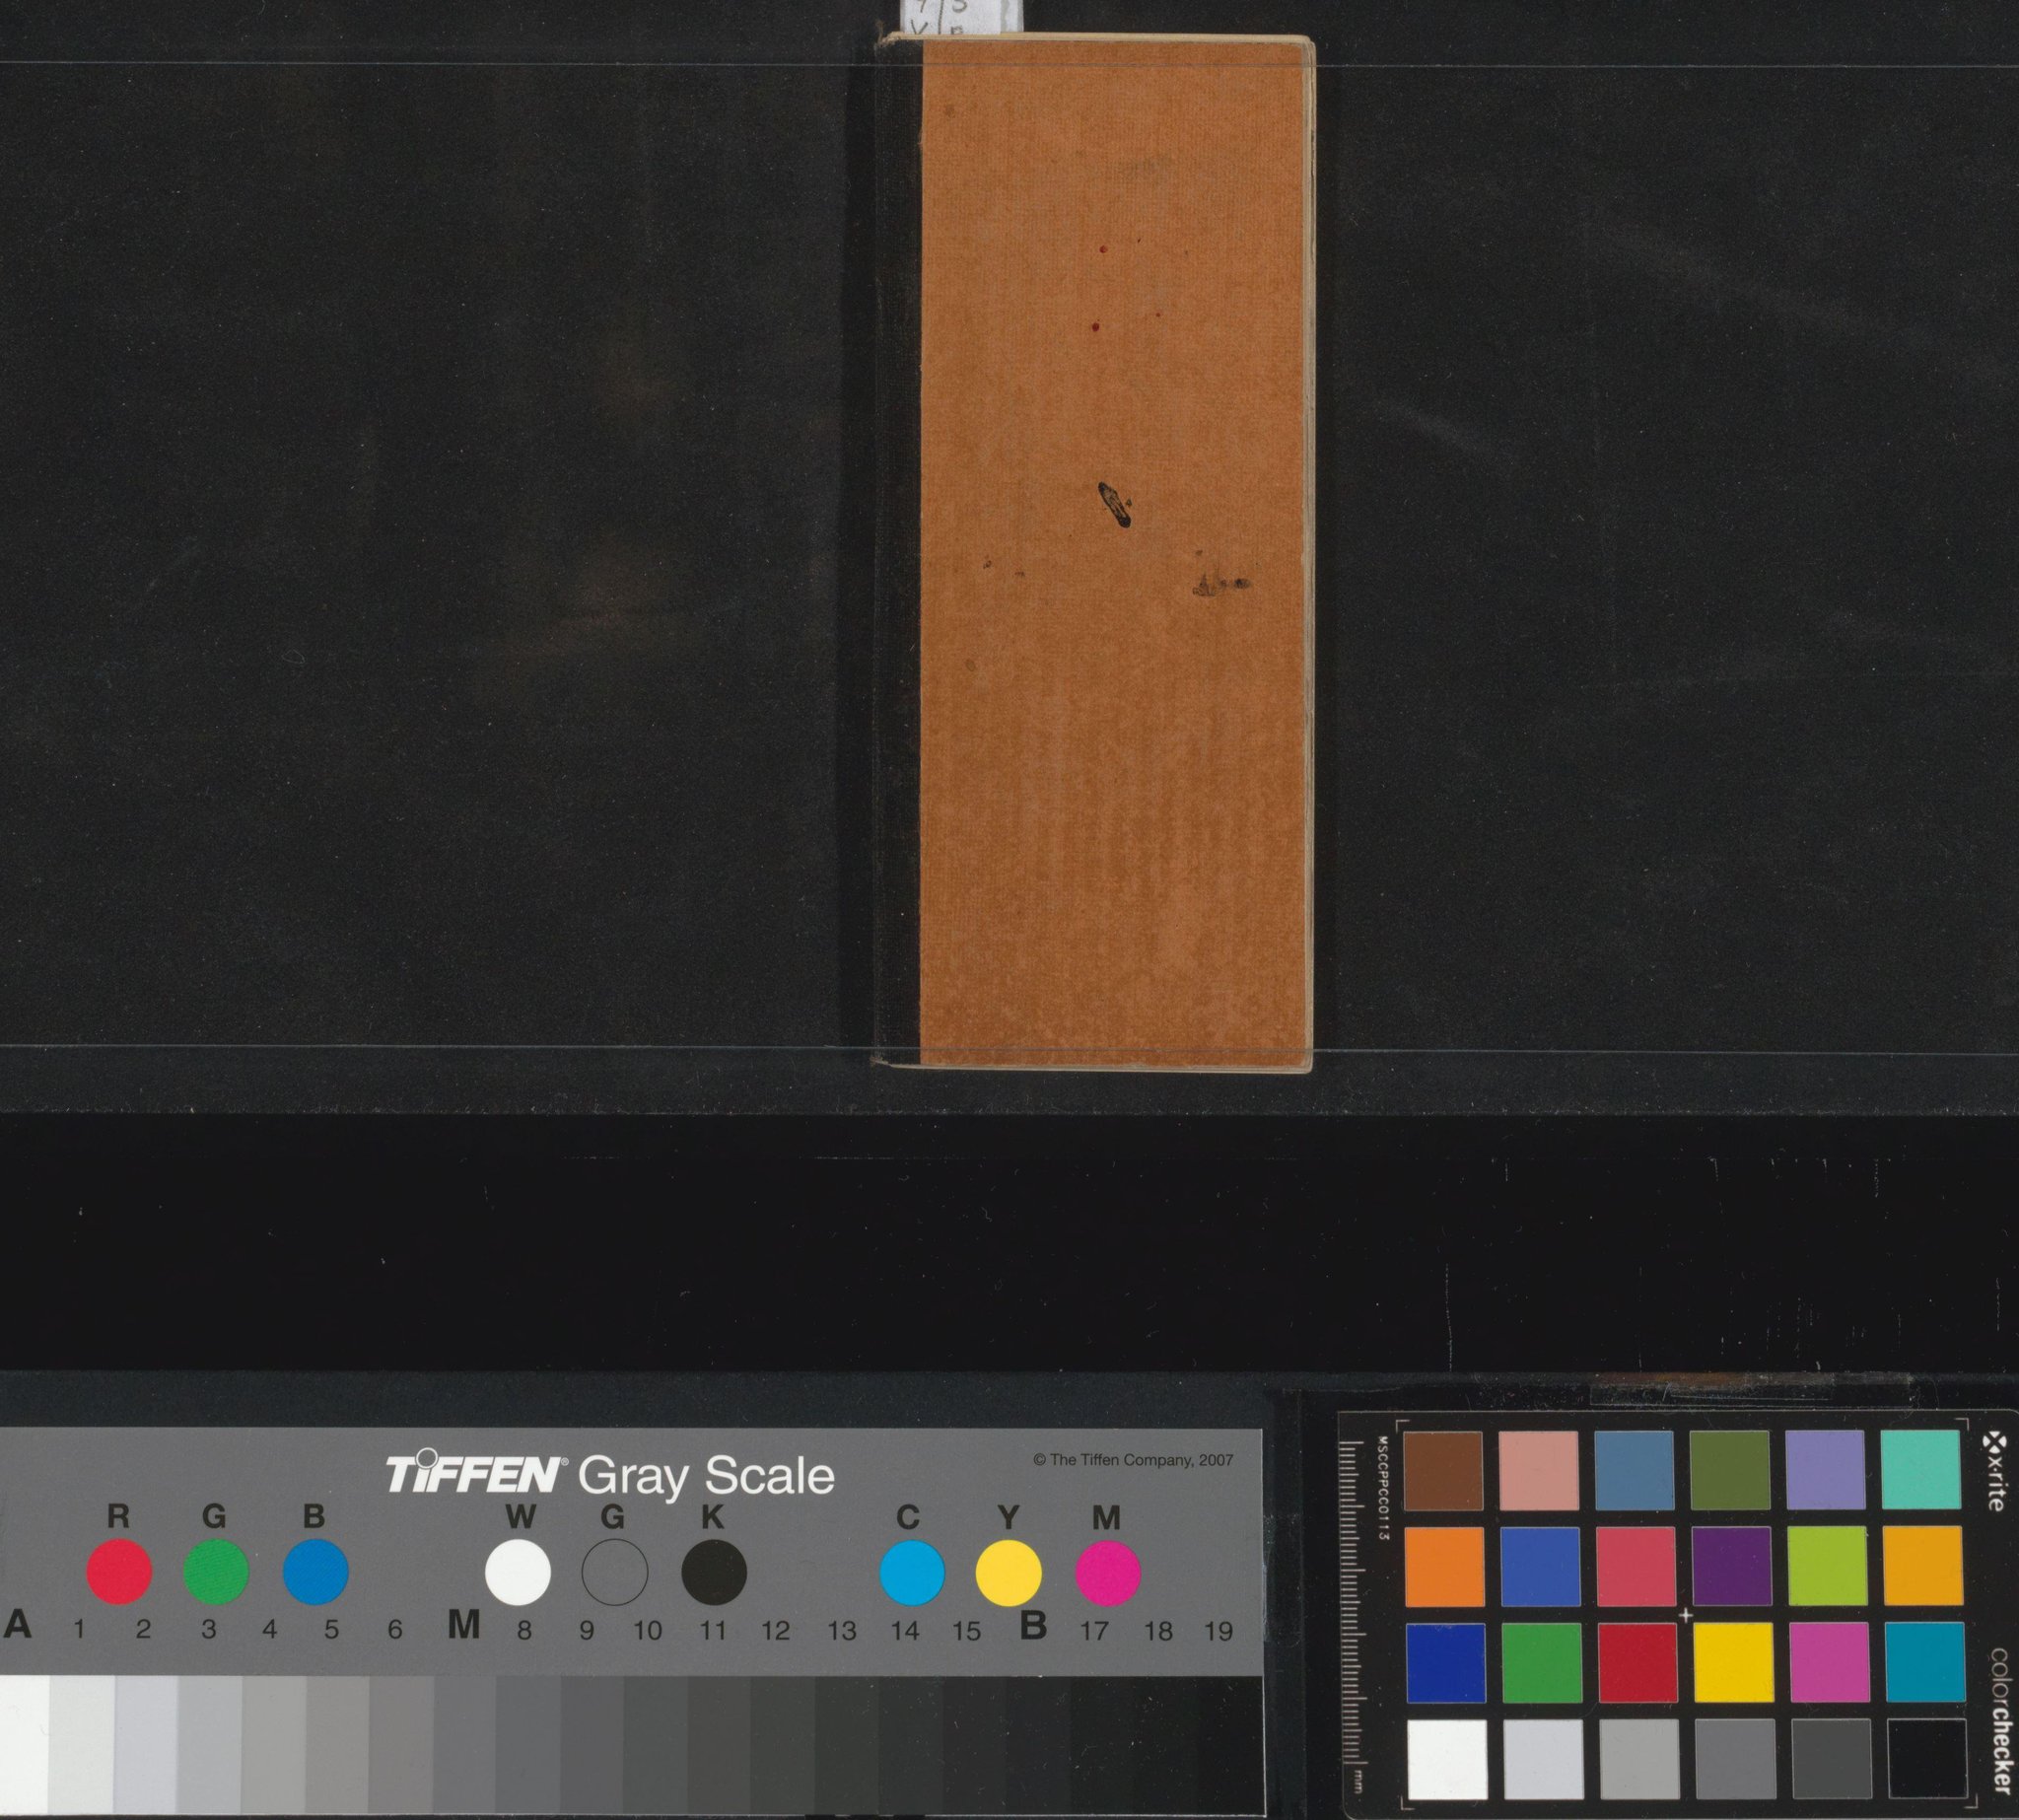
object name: sketchbook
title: Schetsboek met 24 bladen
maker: gerrit willem dijsselhof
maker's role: designer, draughtsman, print maker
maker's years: 1866-1924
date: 1876-1924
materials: cardboard, chalk, linen, paper, pencil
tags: ornaments ~ art, work of applied art (+ types of art), architecture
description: De volgende bladen uit het schetsboek zijn blanco: 1(V), 3(V) t/m 6(V), 8(V), 9(R), 10(V), 12(V) en 14(V) t/m 23(V).